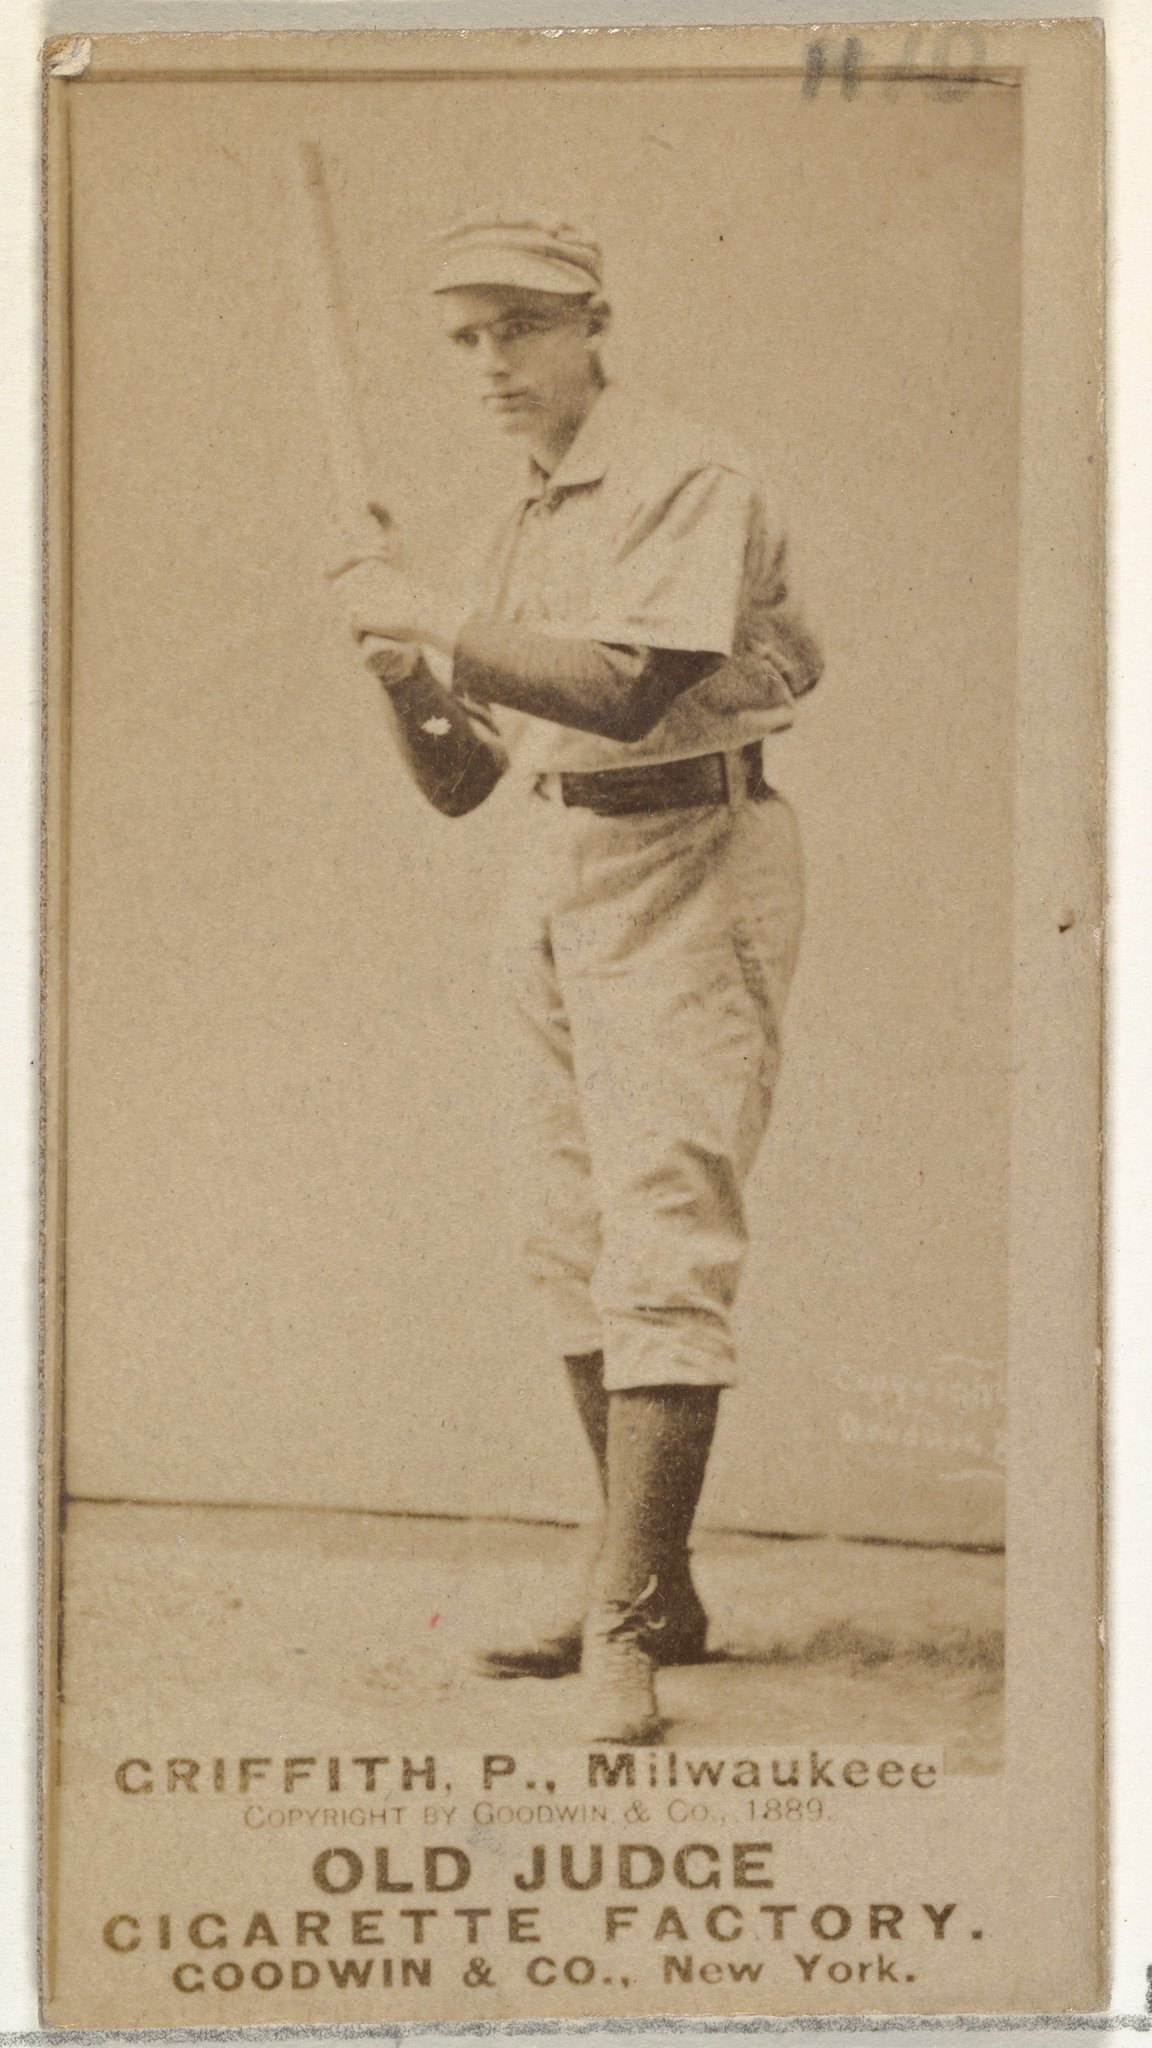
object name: baseball card, photograph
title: Clark Calvin "Old Fox" Griffith, Pitcher, Milwaukee, from the Old Judge series (N172) for Old Judge Cigarettes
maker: goodwin & company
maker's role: publisher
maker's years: 1850-1950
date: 1889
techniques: albumen silver print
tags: men,portraits,baseball,athletes